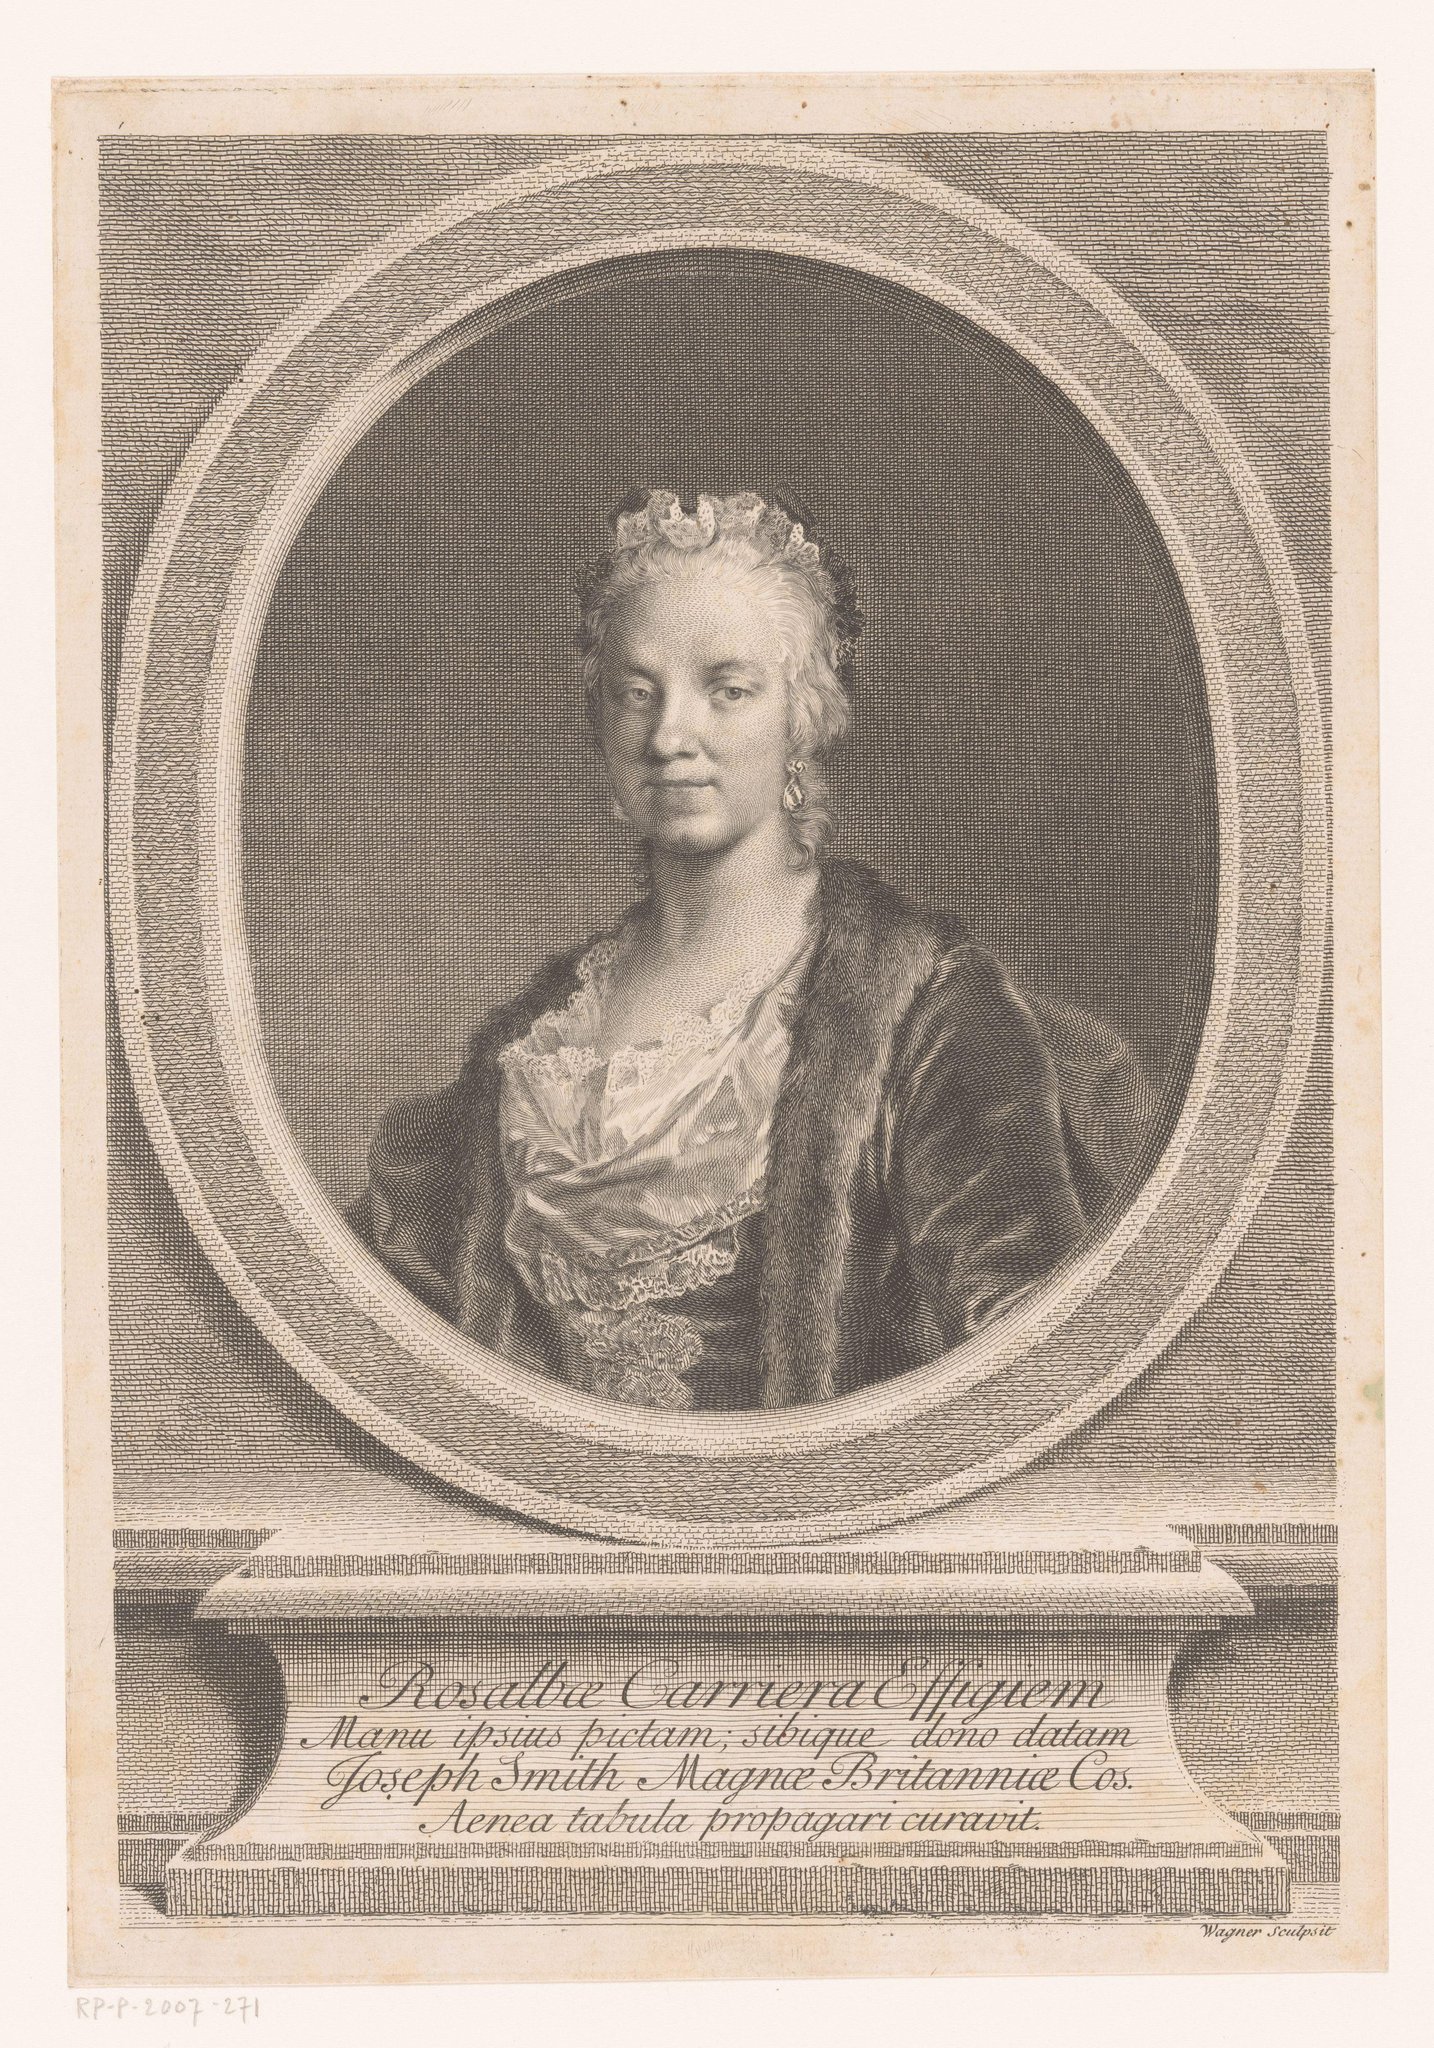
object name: print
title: Portret van Rosalba Carriera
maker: joseph wagner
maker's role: painter, print maker, publisher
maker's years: 1706-1780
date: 1745-1780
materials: paper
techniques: etching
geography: rome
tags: venice, draughtsman, rosalba carriera, historical persons, portrait, self-portrait of artist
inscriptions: collector's mark: Lugt 2760, number: ‘4. [...] : n4:’, collector's mark: Lugt 2228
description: Prent naar het zelfportret in pastel dat zich bevindt in de Royal Collection te Londen.